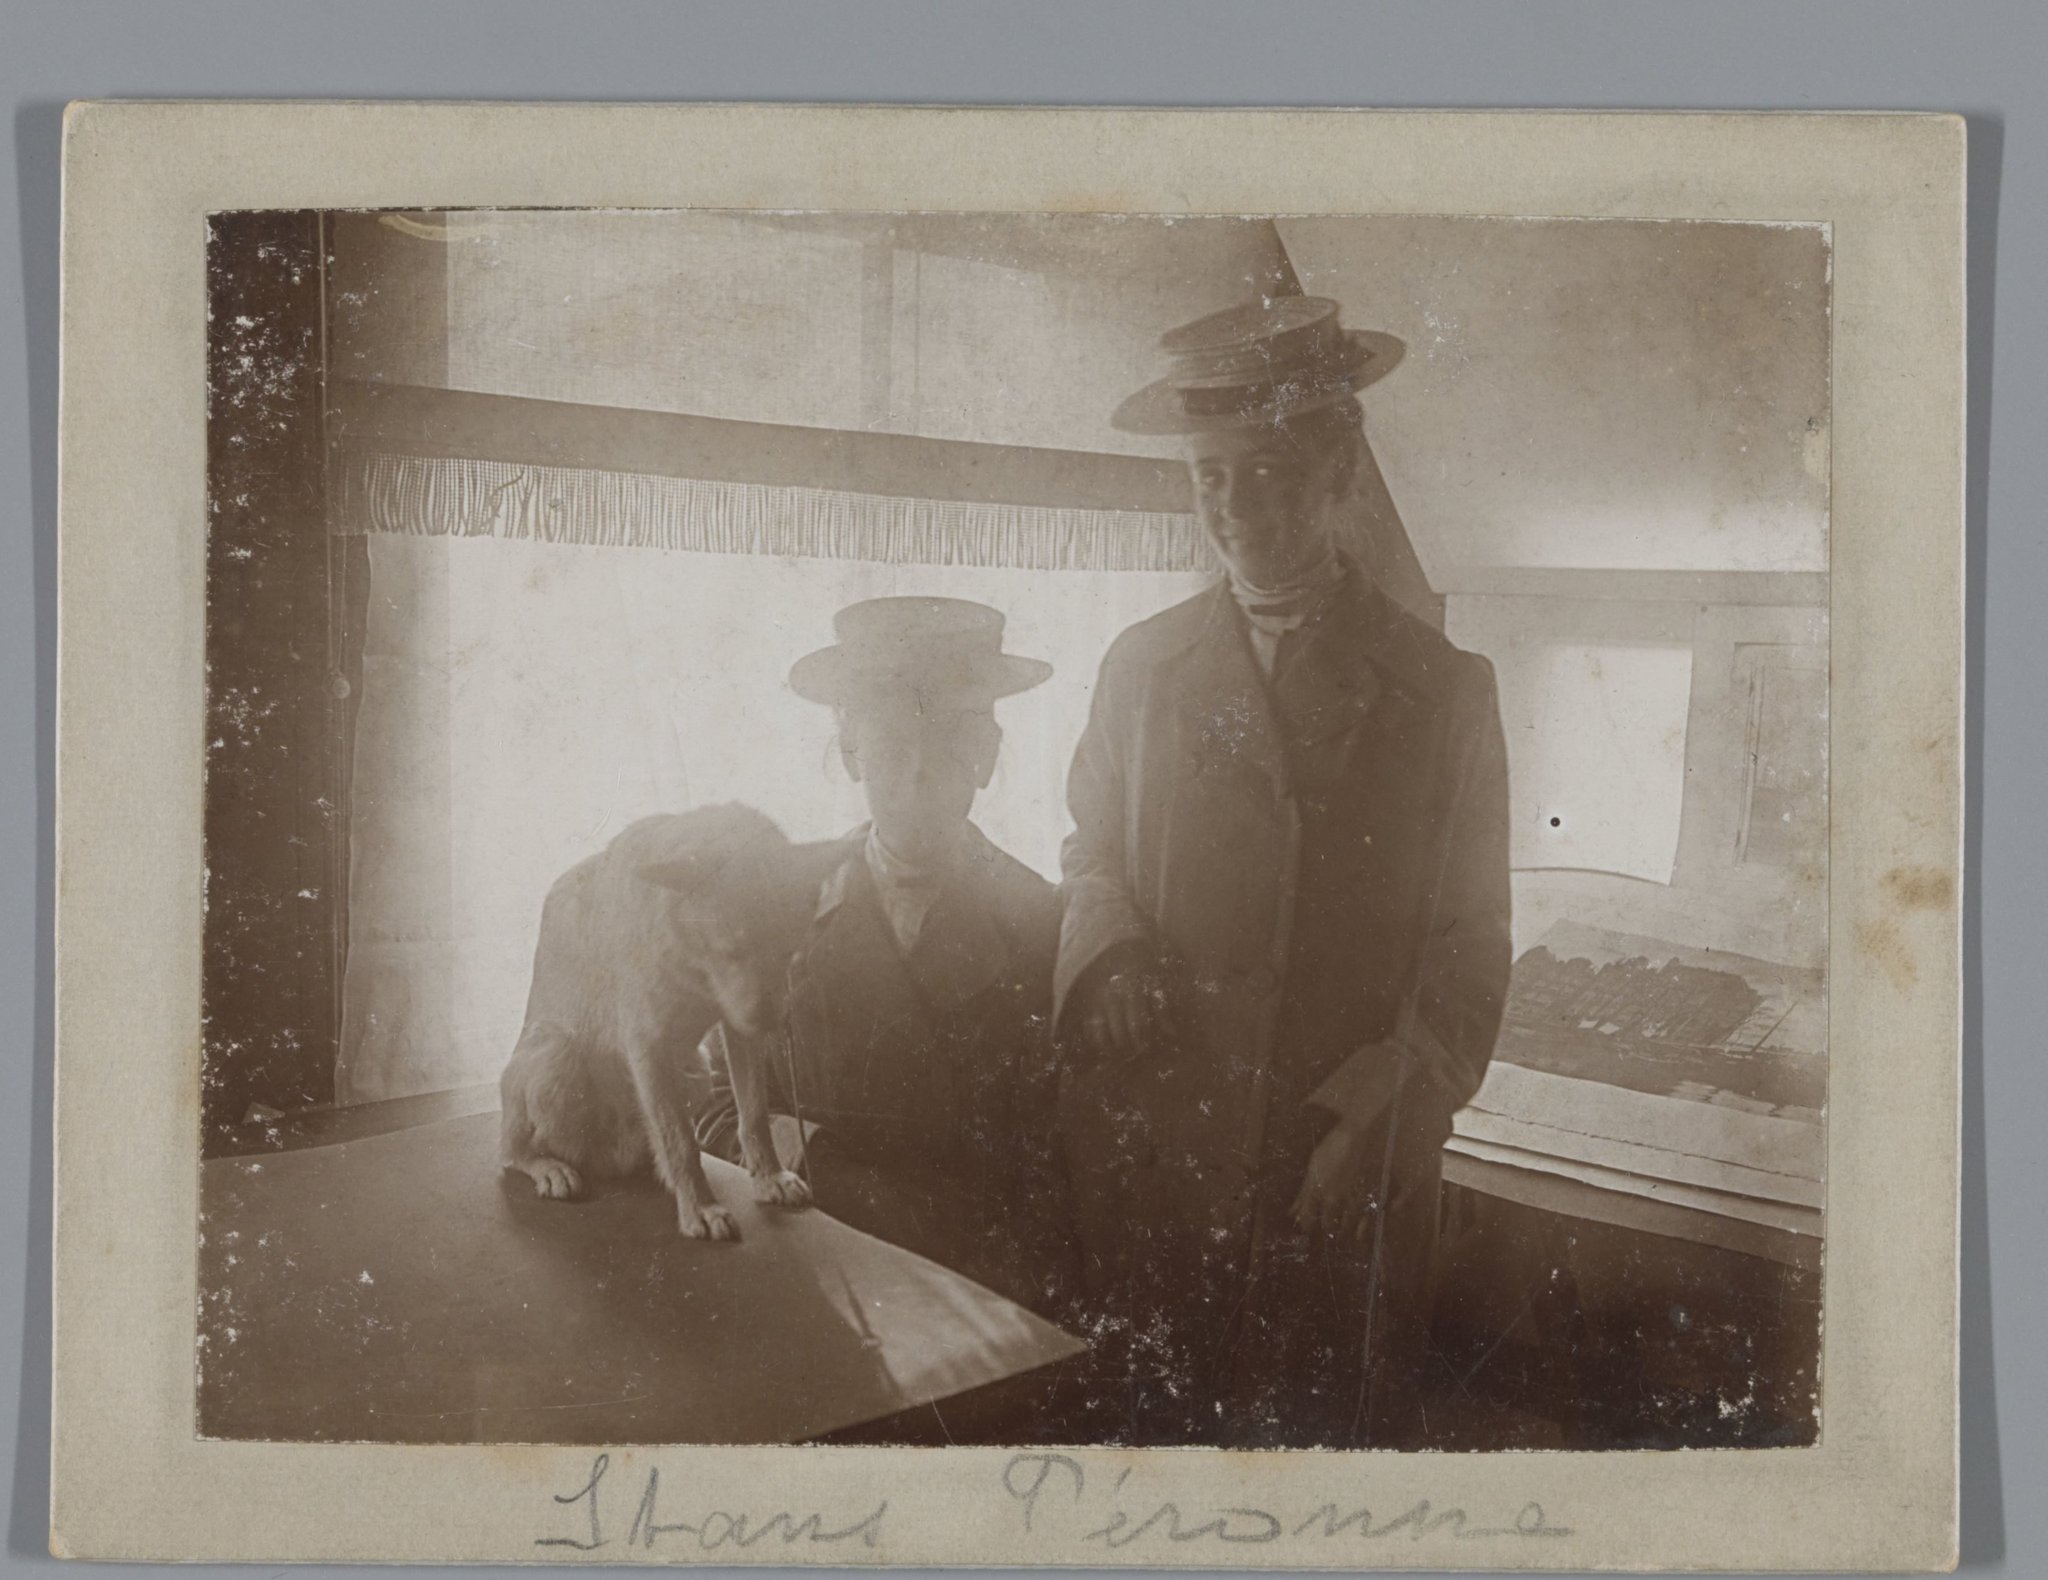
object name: photograph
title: Peronne en Stand Arntzenius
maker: willem witsen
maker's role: draughtsman, painter, print maker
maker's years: 1860-1923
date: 1860-1915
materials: cardboard, paper, photographic support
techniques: collodion silver print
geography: amsterdam